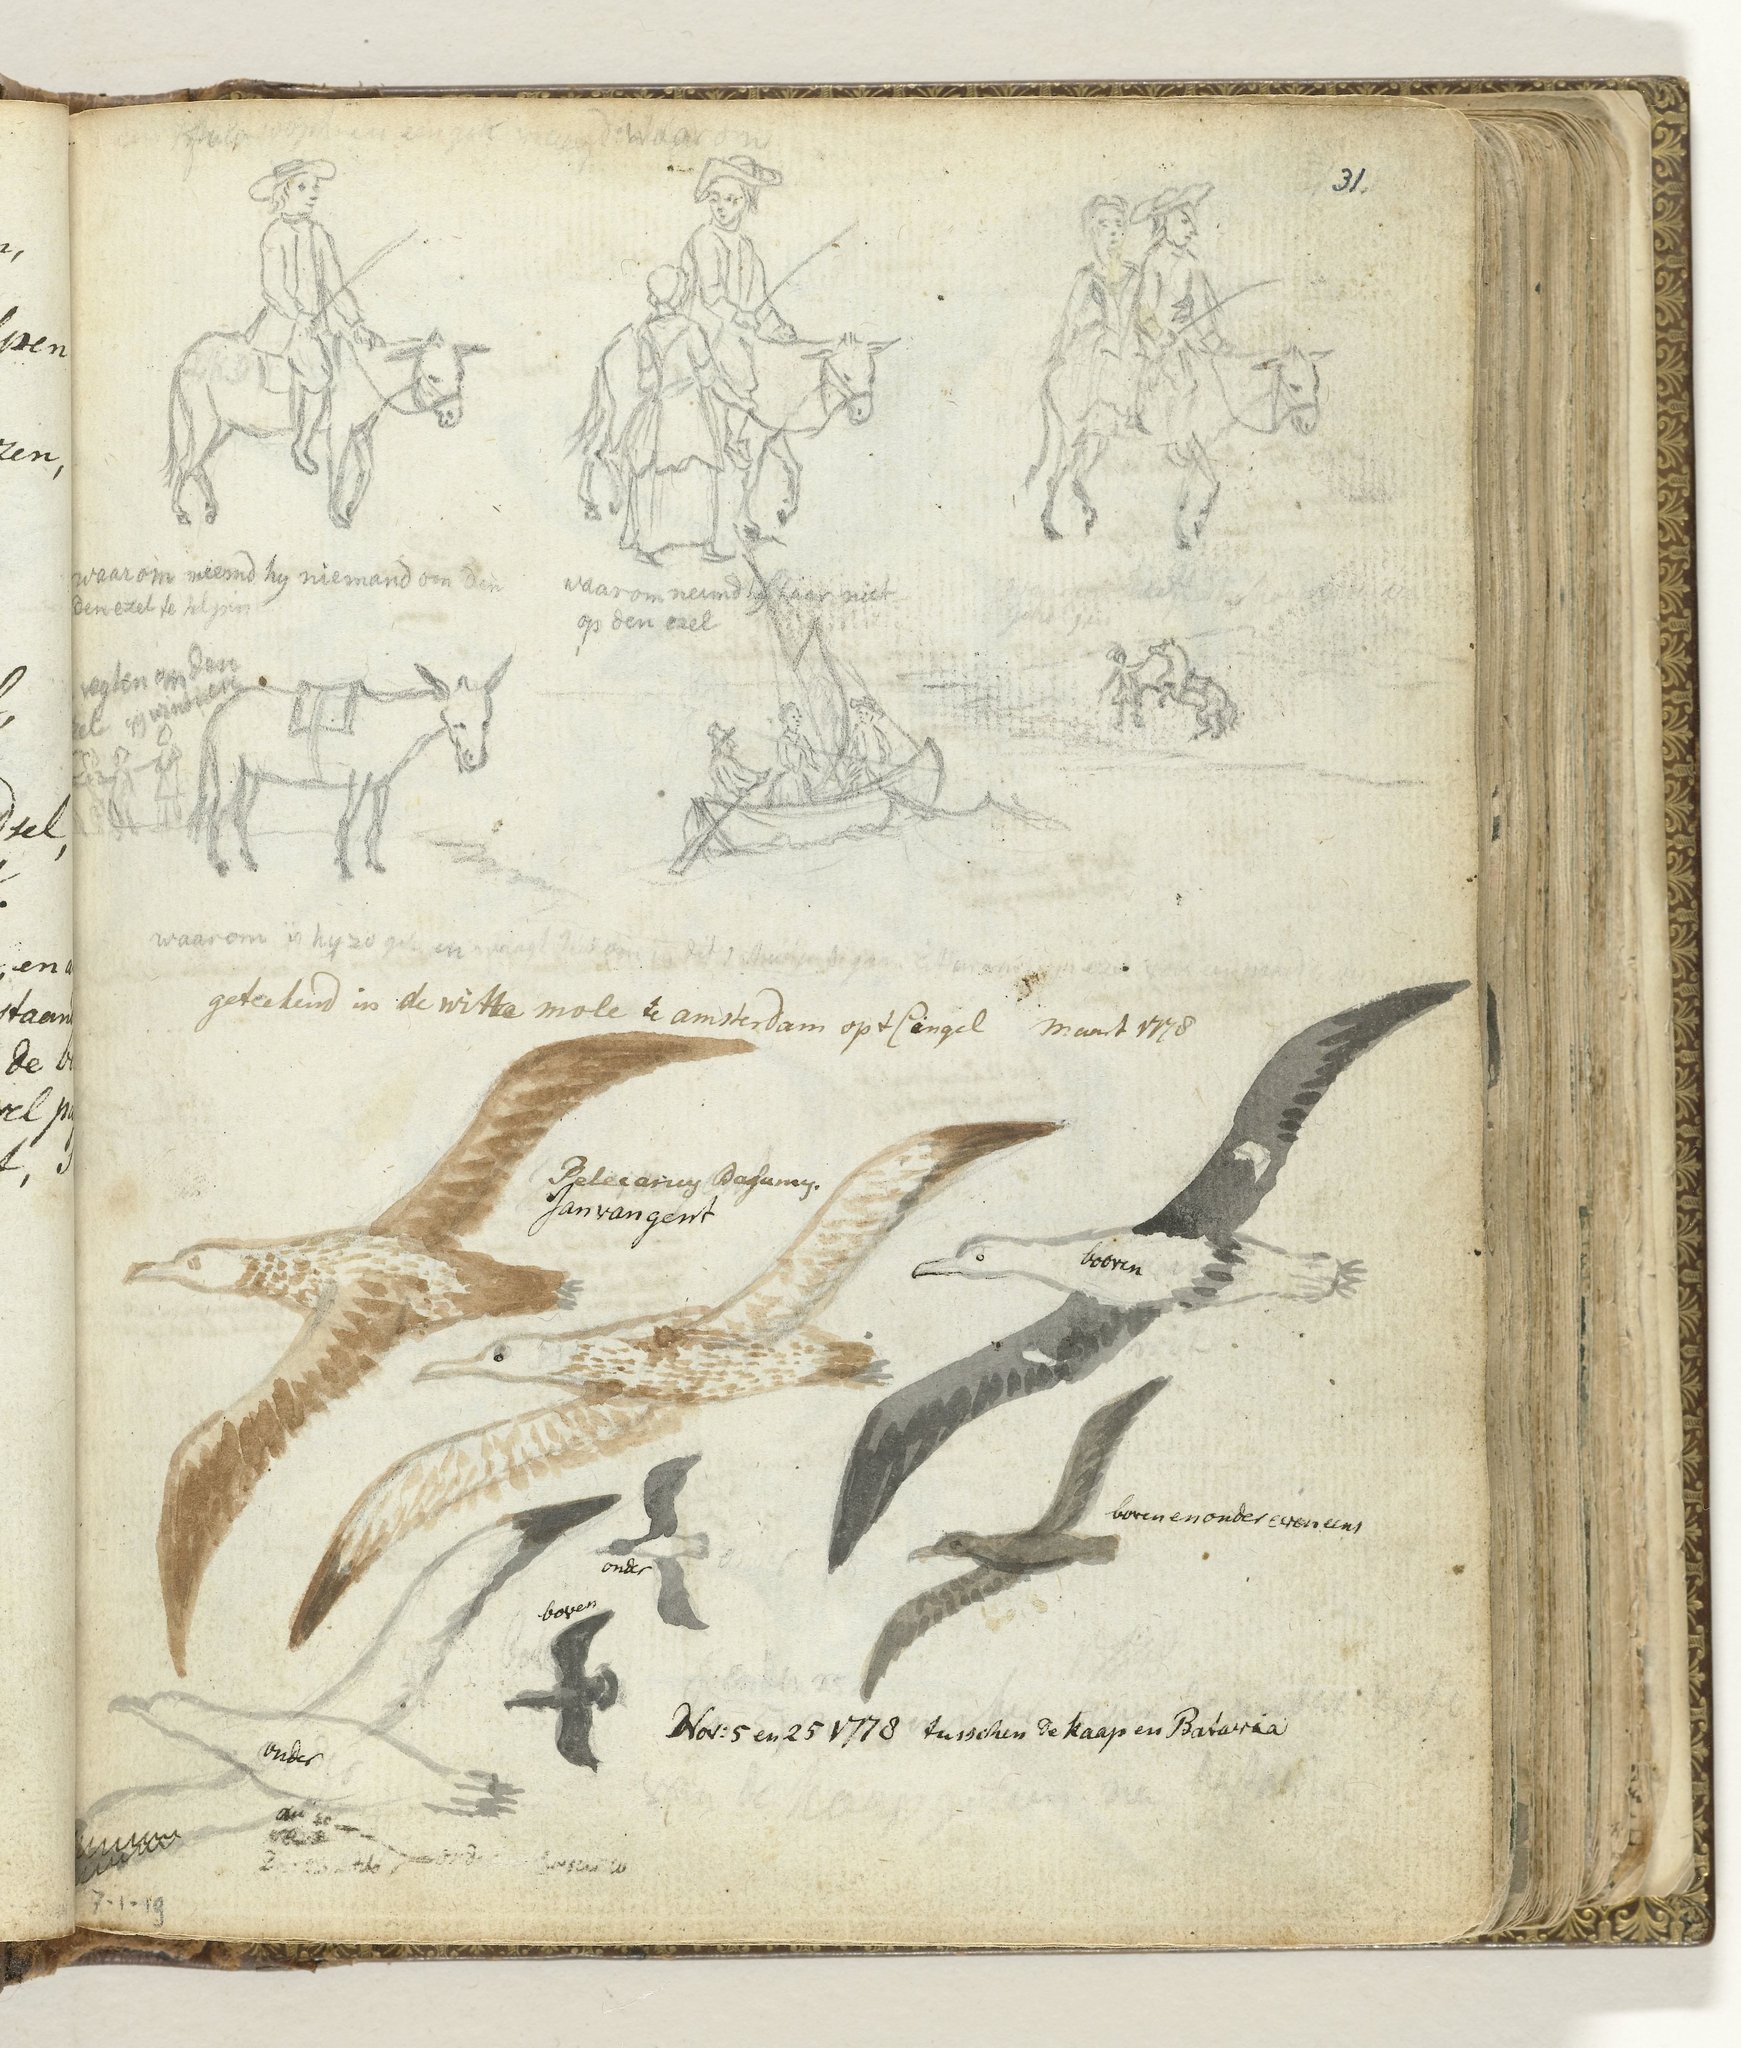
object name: drawing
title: Vertelling over man en ezel. Zeevogels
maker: jan brandes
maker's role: draughtsman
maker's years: 1743-1808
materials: ink, paper, pencil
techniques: pen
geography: cape of good hope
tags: ass, donkey, shore-birds and wading-birds: gull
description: Serie potloodschetsen. Bruin- en zwart-witte tekeningen van Jan van Genten. Met opschrift in potlood en pen. Onderdeel uit het schetsboek van Jan Brandes, dl. 1 (1808), p. 31.